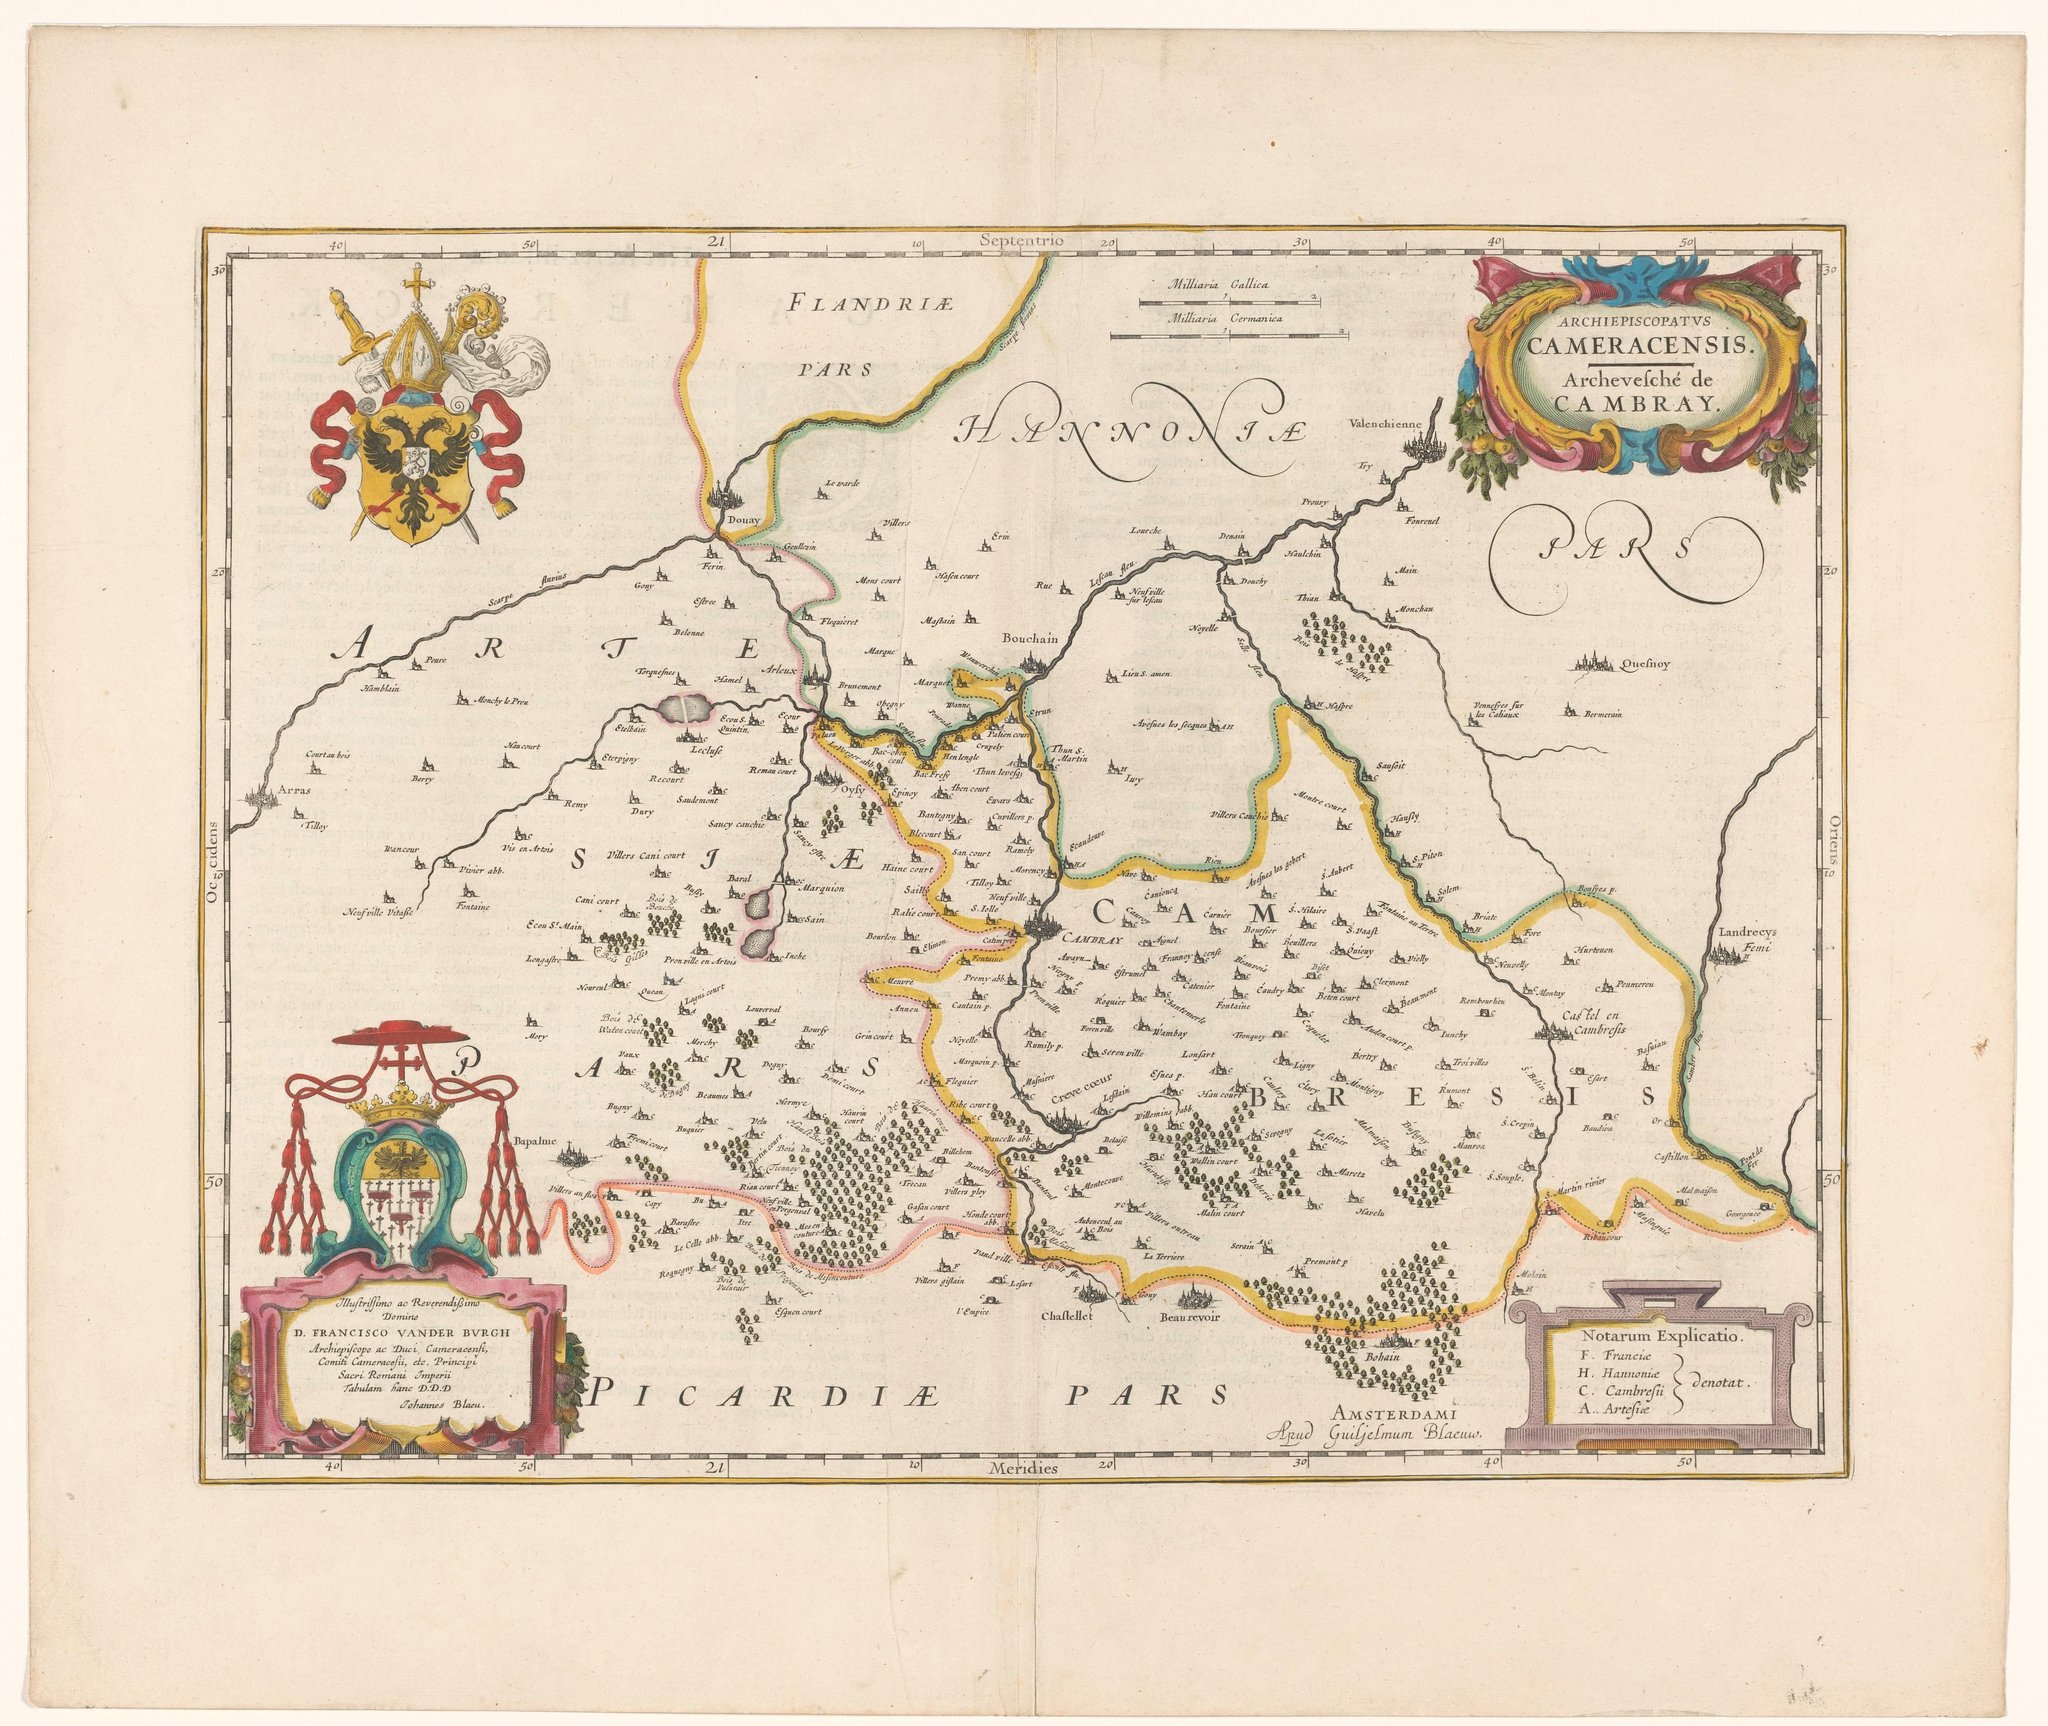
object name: print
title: Archiepiscopatus Cameracensis. Archevesché de Cambray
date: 1642-1661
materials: paper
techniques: engraving, letterpress printing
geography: amsterdam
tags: maps of separate countries or regions, coat of arms (as symbol of the state, etc.) (+ province; provincial)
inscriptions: collector's mark: Lugt 2228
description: Prent gebruikt in: Blaeu, Willem Janszoon en Johannes Willemszoon Blaeu. Toonneel des Aerdrycx, ofte nieuwe Atlas, dat is de beschryving van alle landen. 3 delen. Amsterdam: Johannes Willemszoon Blaeu, 1642-1643, dl. 2 (1642). Of in: Blaeu, Willem Janszoon en Johannes Willemszoon Blaeu. Toonneel des aerdrycx, ofte nieuwe Atlas, dat is de beschryving van alle landen. 4 delen. Amsterdam: Johannes Willemszoon Blaeu, 1649-1650, dl. 2 (1650). Of in: Blaeu, Willem Janszoon en Johannes Willemszoon Blaeu. Toonneel des aerdriicx, ofte nieuwe Atlas, dat is beschryving van alle landen. 6 delen. Amsterdam: Johannes Willemszoon Blaeu, 1658-1661, dl. 2.